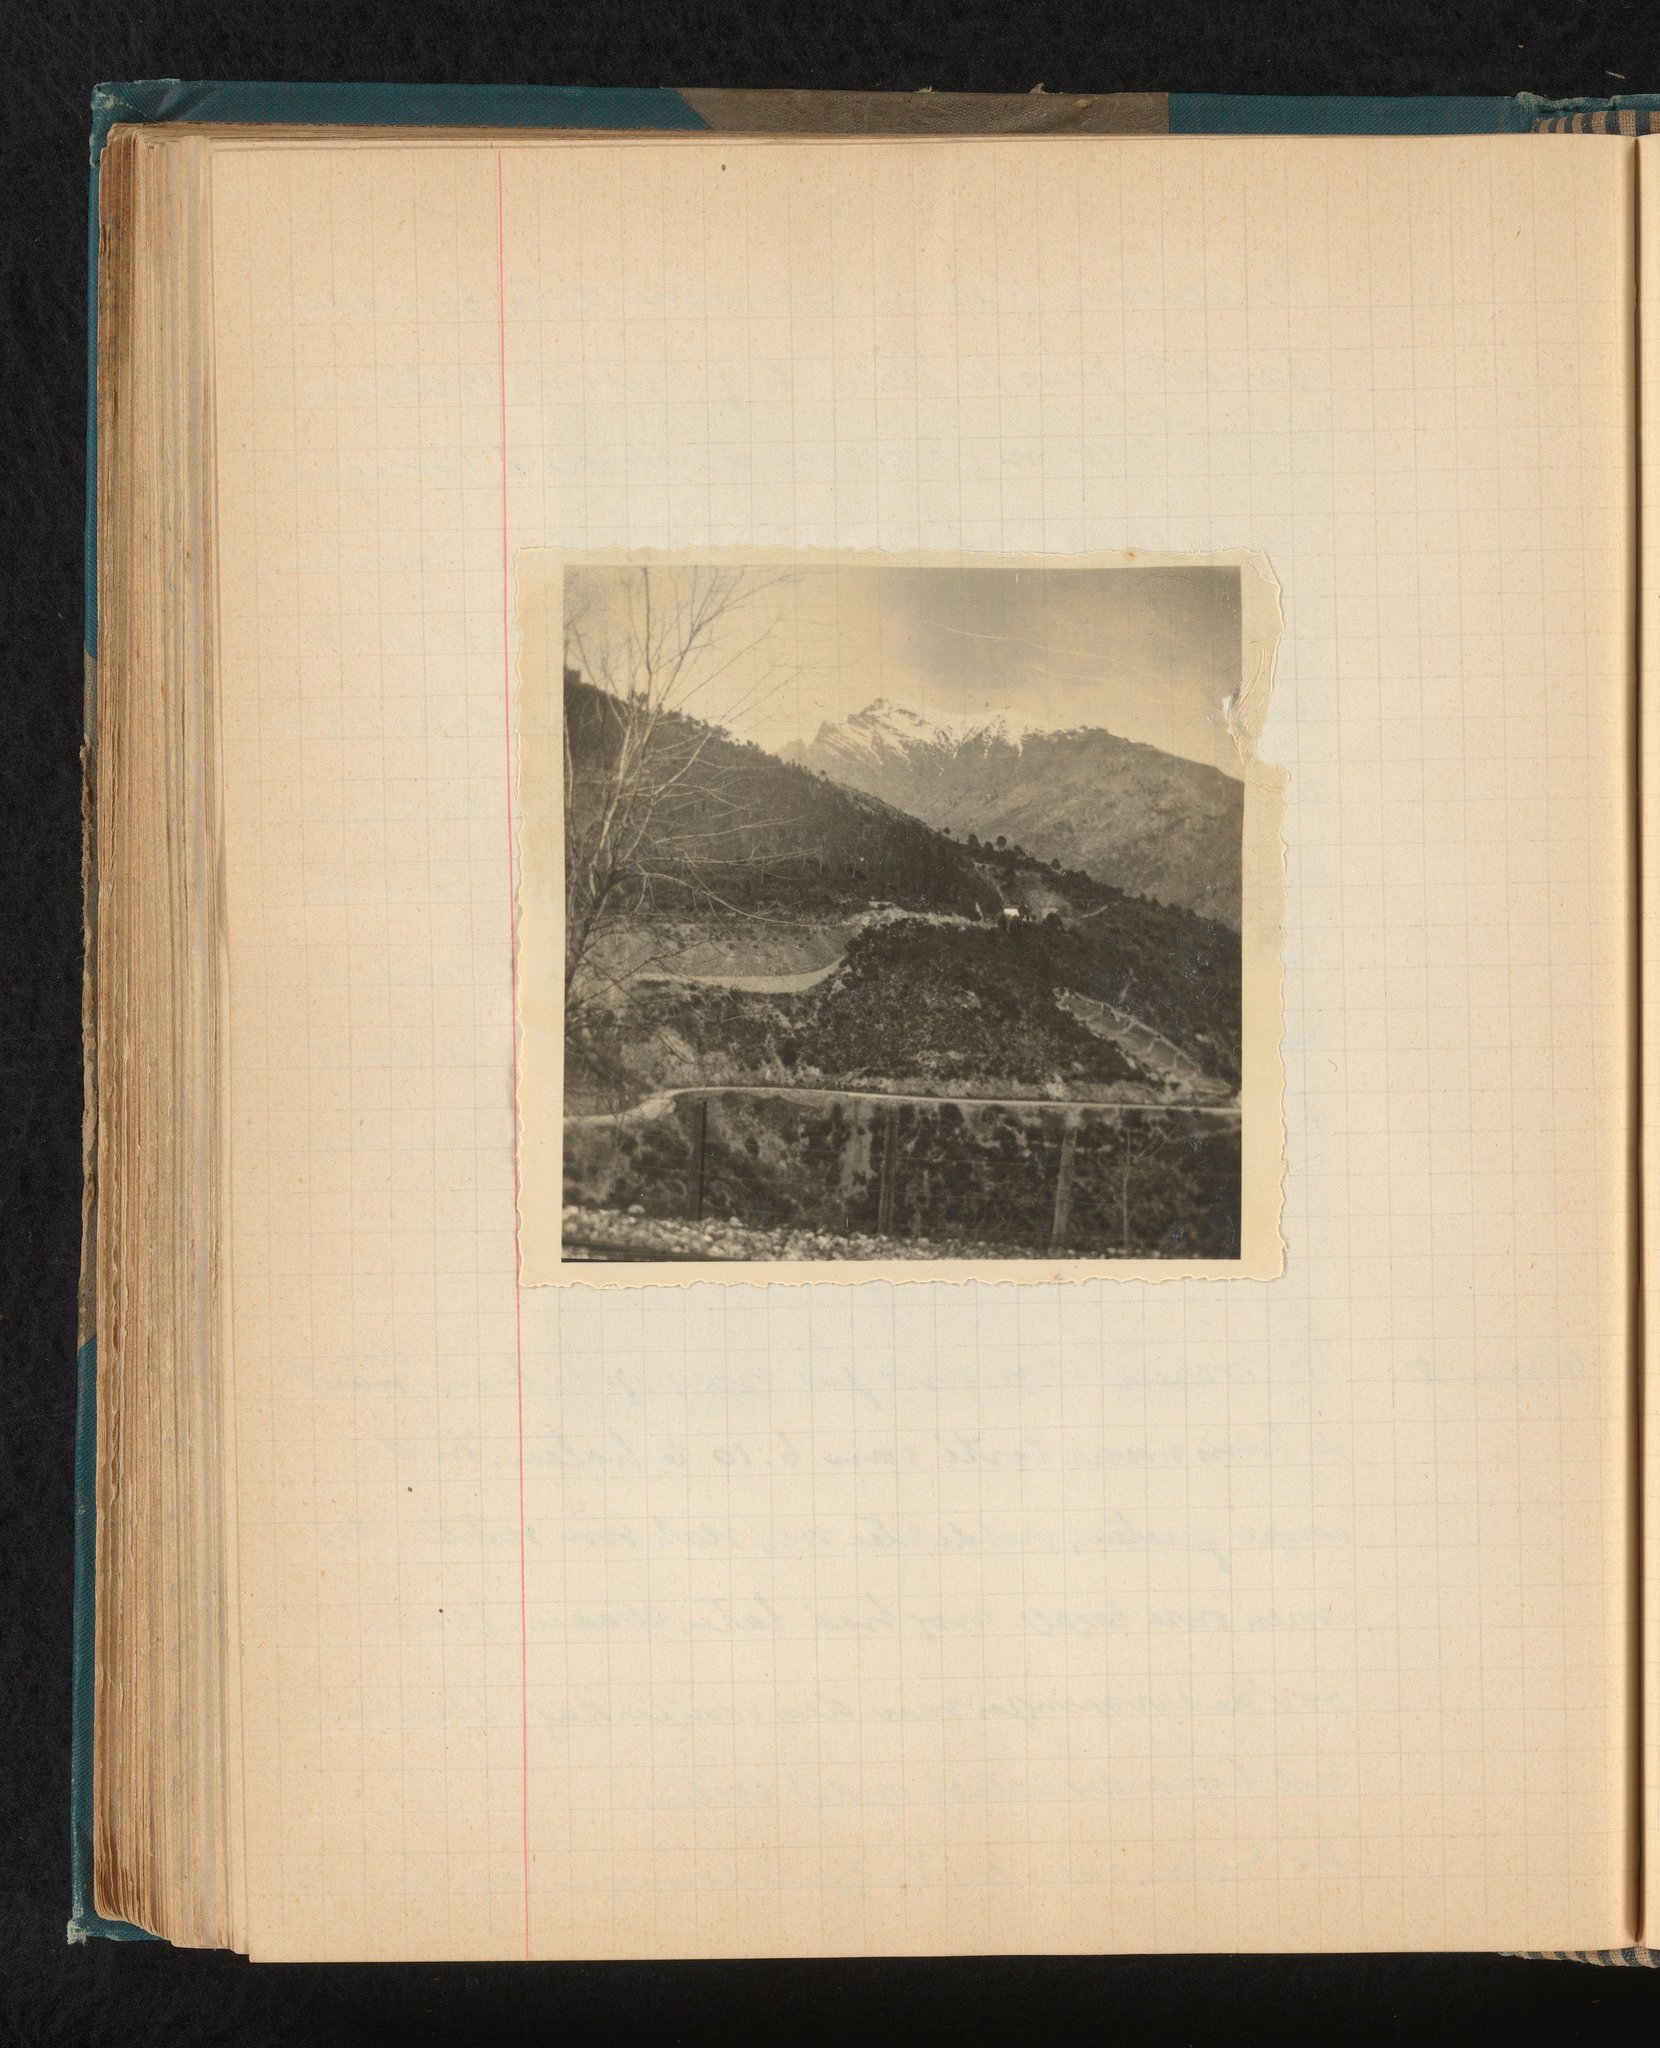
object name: album leaf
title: Gezicht op een berglandschap nabij Vivario, Corsica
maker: théodore van lelyveld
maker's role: painter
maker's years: 1867-1954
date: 1902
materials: paper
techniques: gelatin silver print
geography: corsica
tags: mountain-range, snow peaks